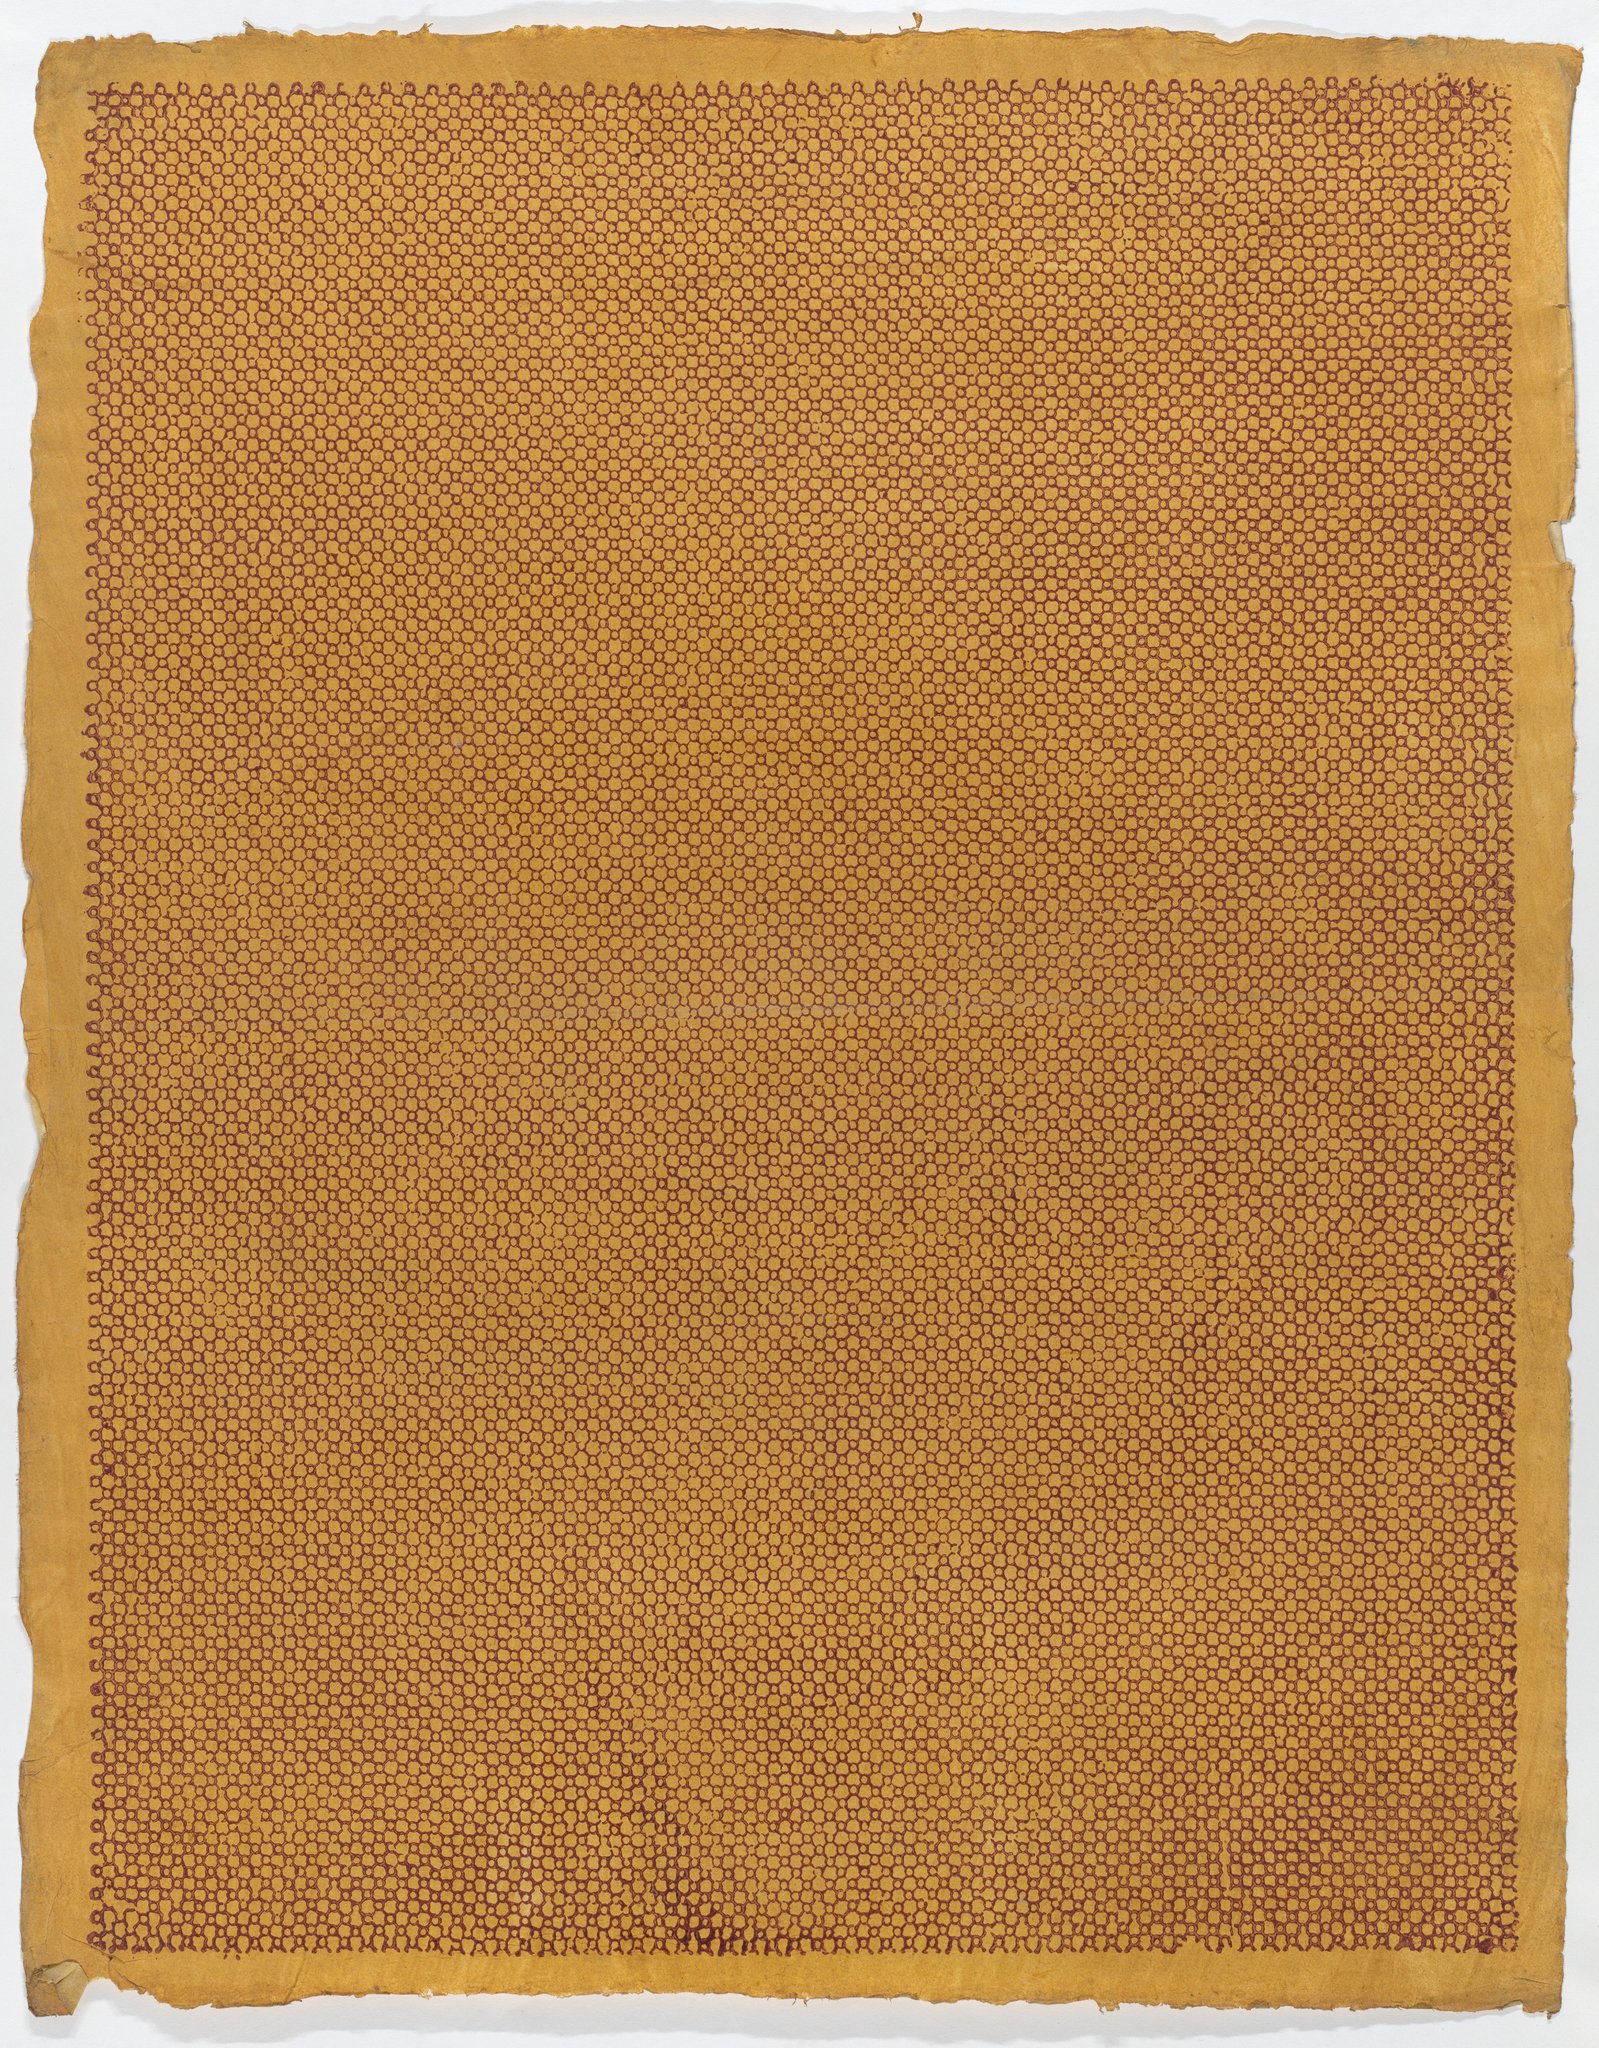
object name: print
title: Sheet with an overall honeycomb pattern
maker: Anonymous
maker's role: artist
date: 1767-1866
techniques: relief print